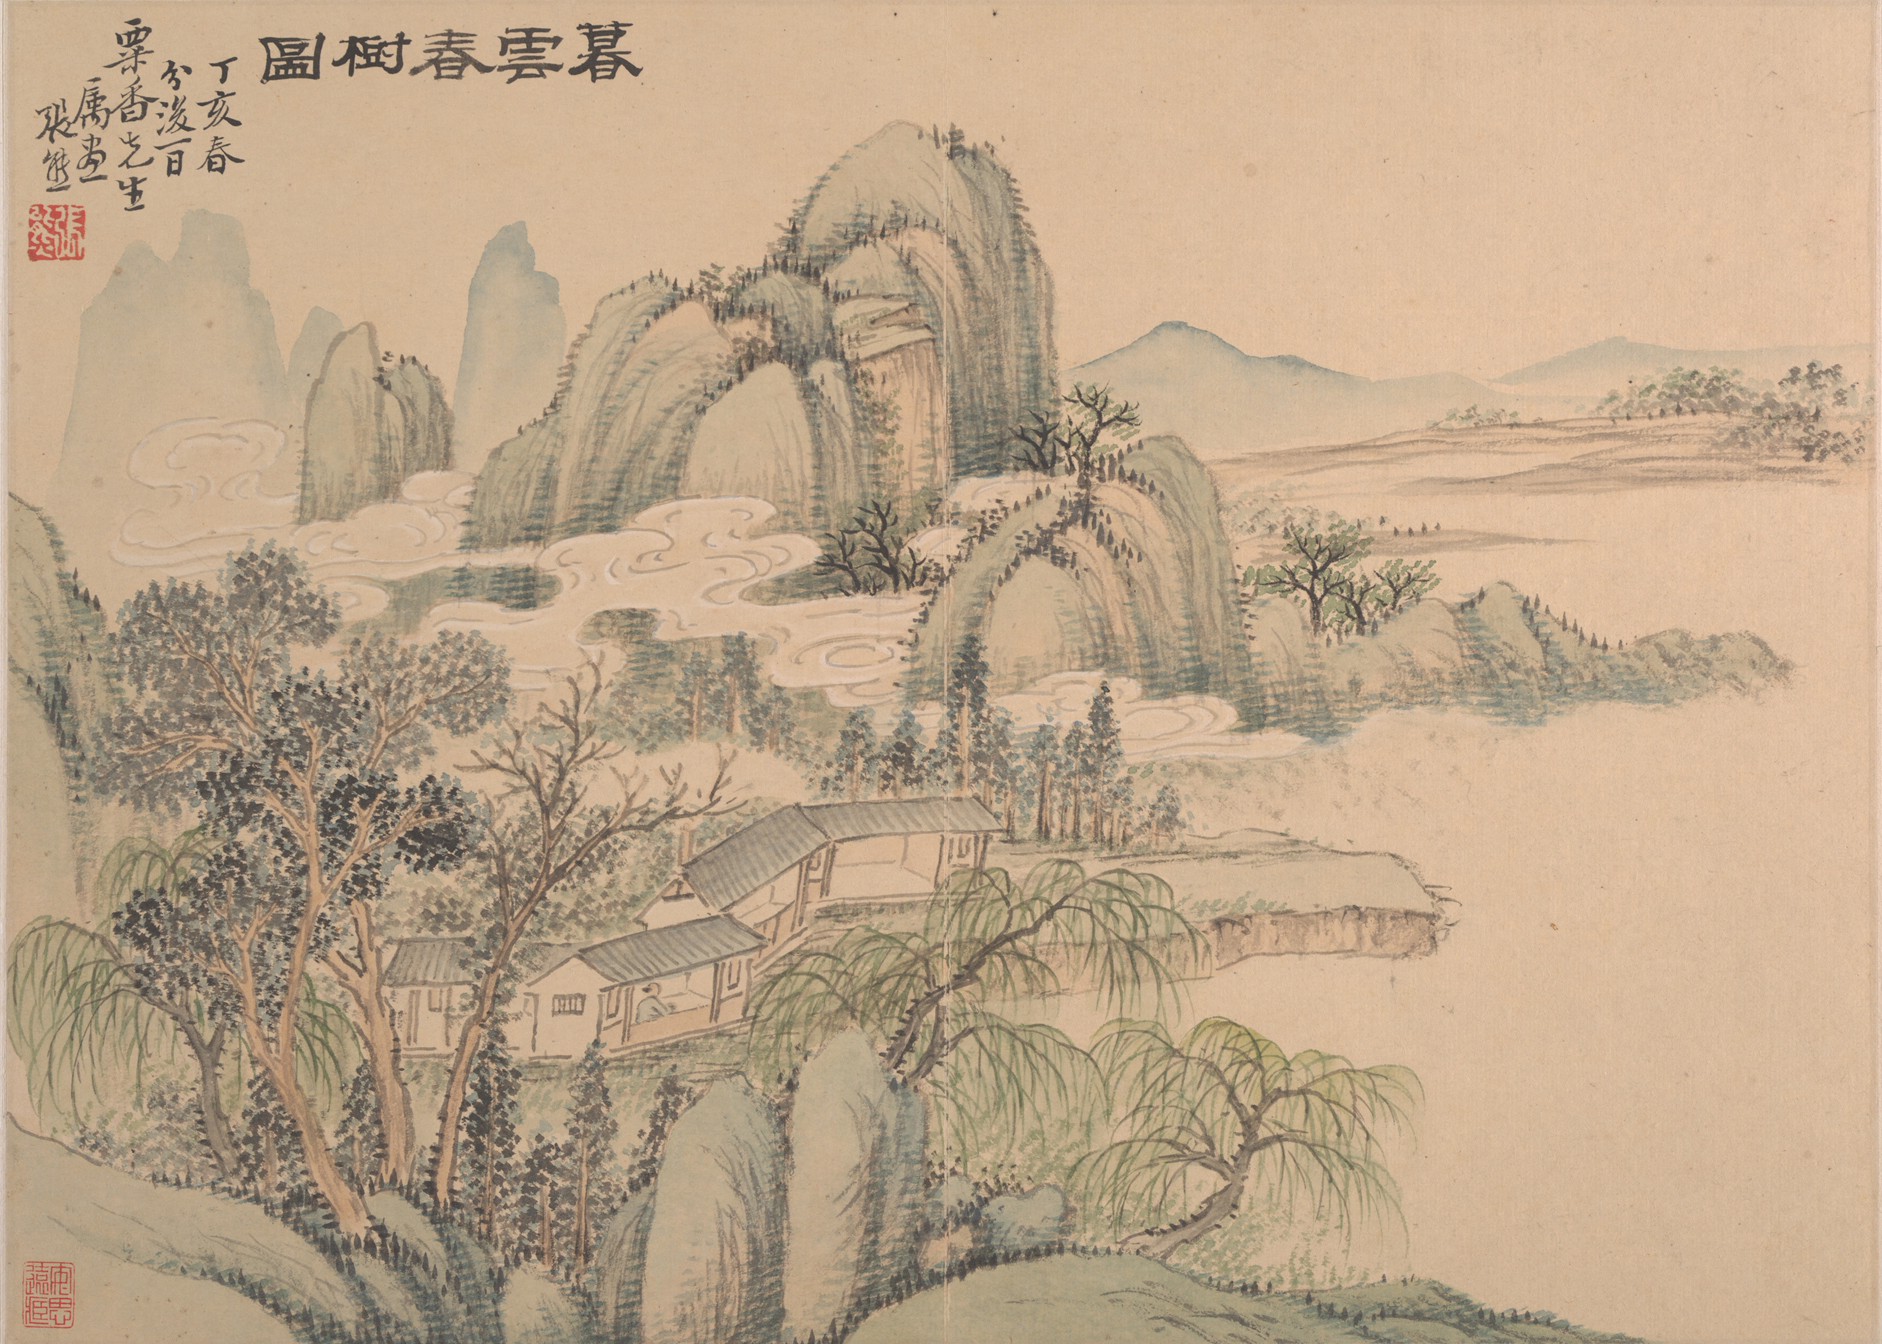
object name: album leaf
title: Landscape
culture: chinese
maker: zhang xiong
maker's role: artist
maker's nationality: chinese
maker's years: 1803-1886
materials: ink, paper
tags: landscapes,pavilions